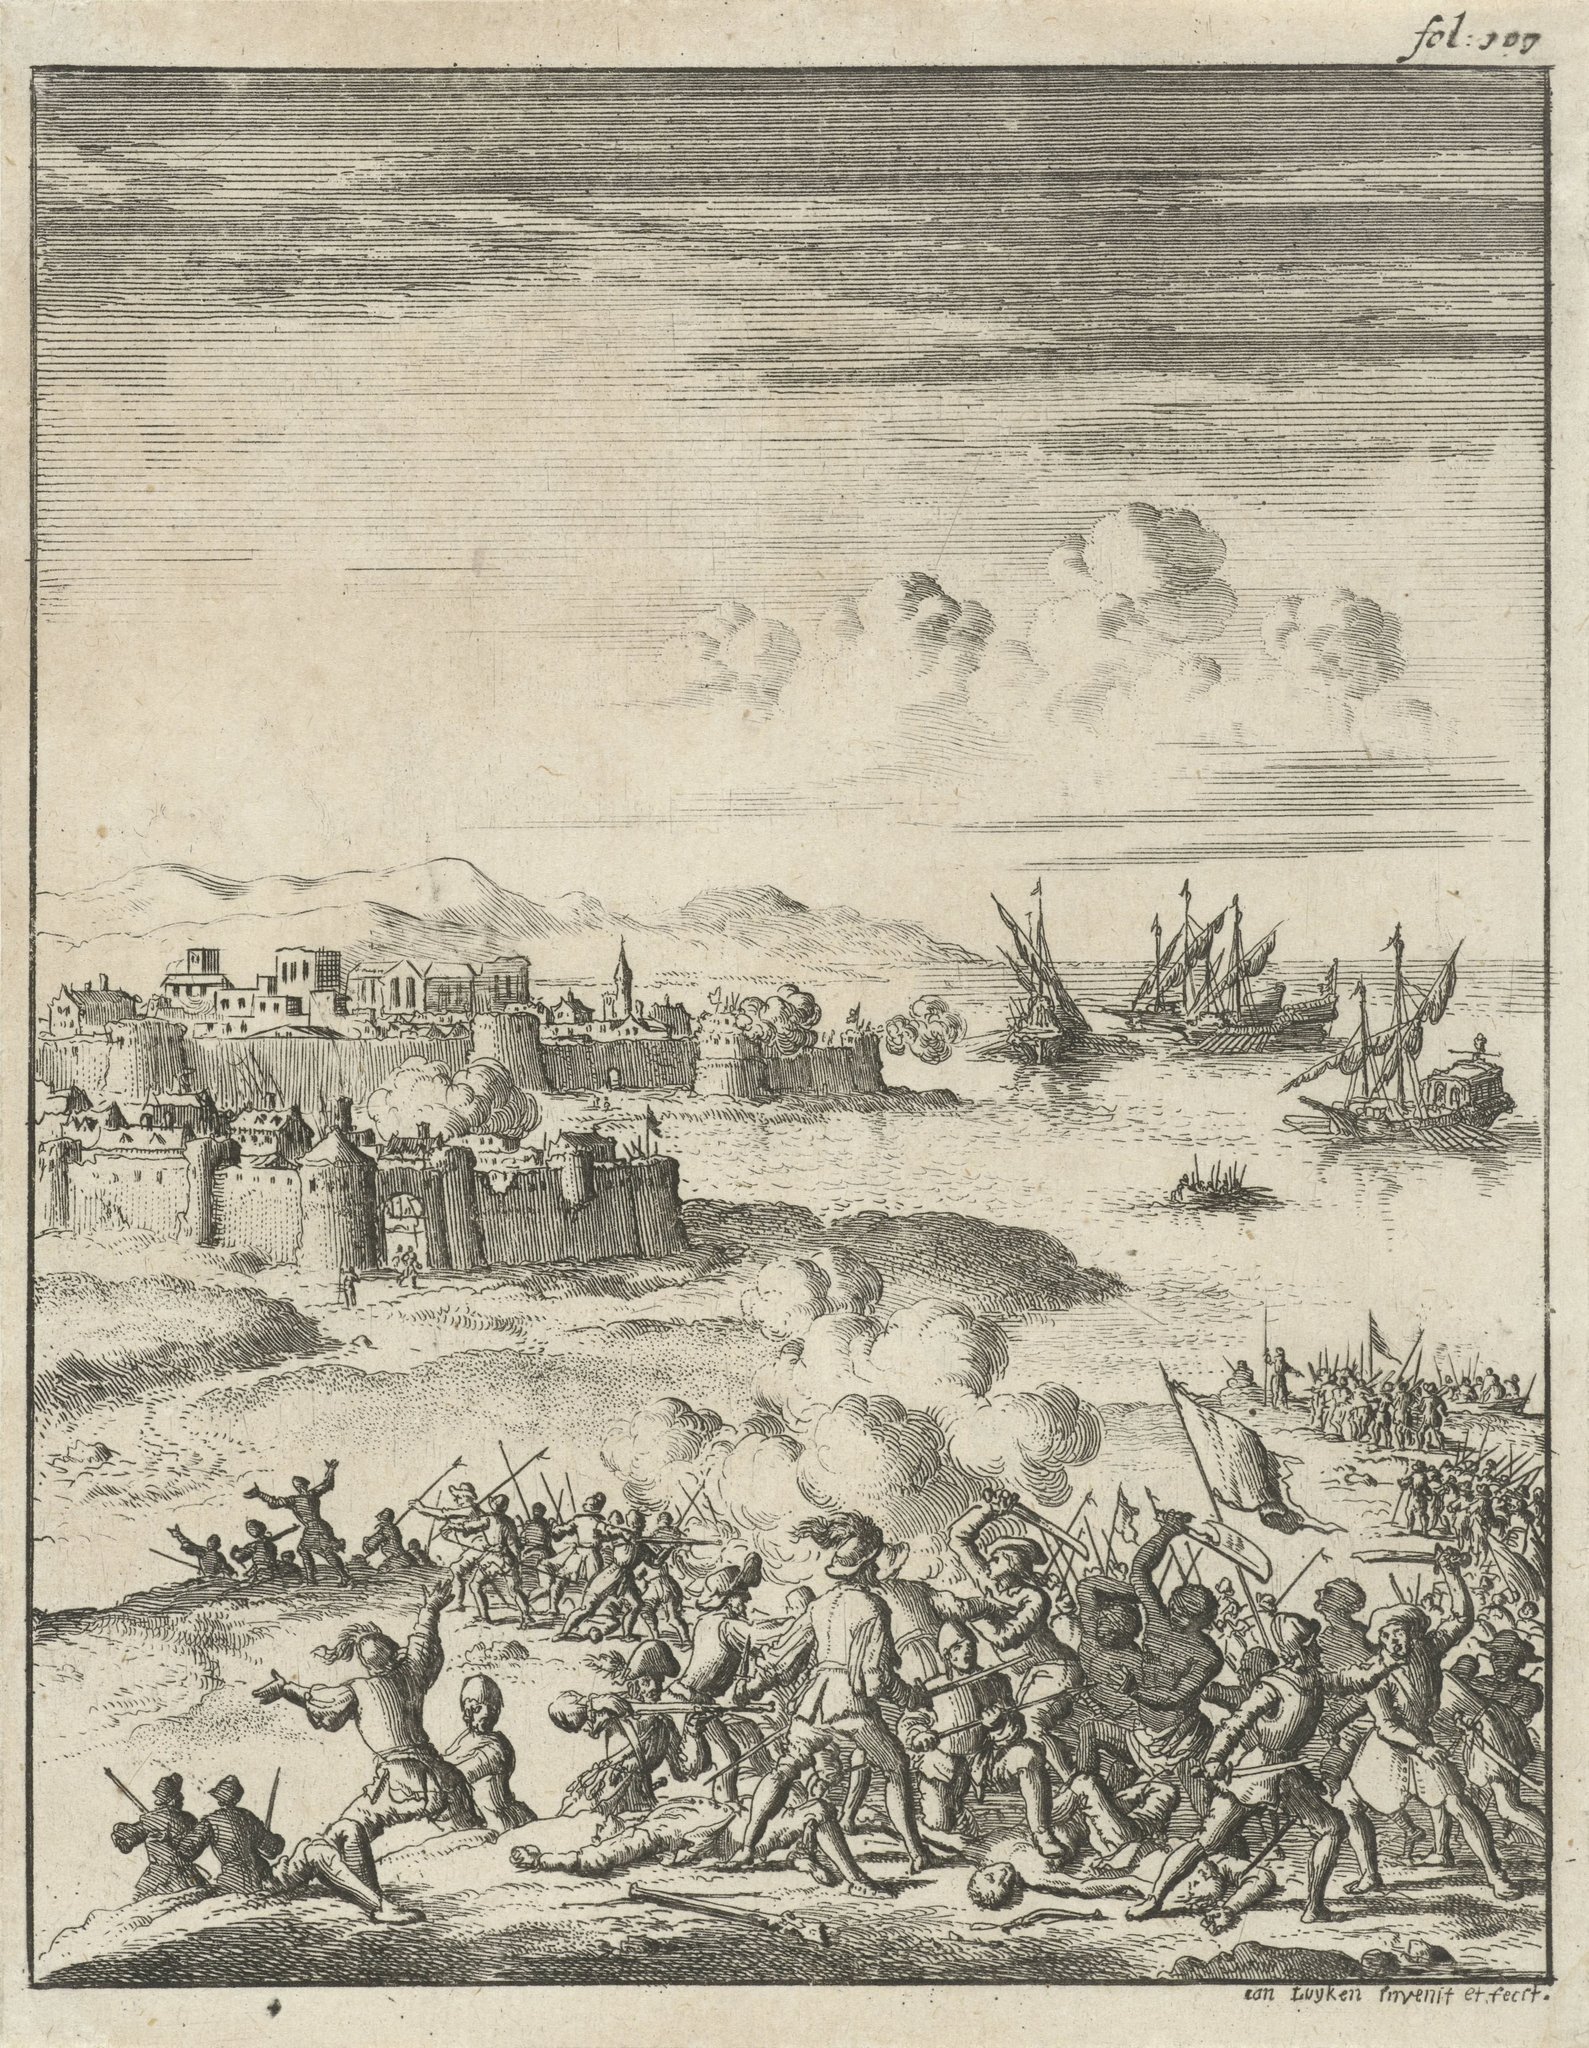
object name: print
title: Belegering van een stad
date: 1684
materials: paper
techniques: etching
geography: amsterdam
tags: siege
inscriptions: collector's mark: Lugt 2228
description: Prent uit: Dan, Pierre. Historie van Barbaryen, en des zelfs zee-roovers (...). 2 dln. Amsterdam: Jan Claesz ten Hoorn, 1684, dl. 1, p. 107.